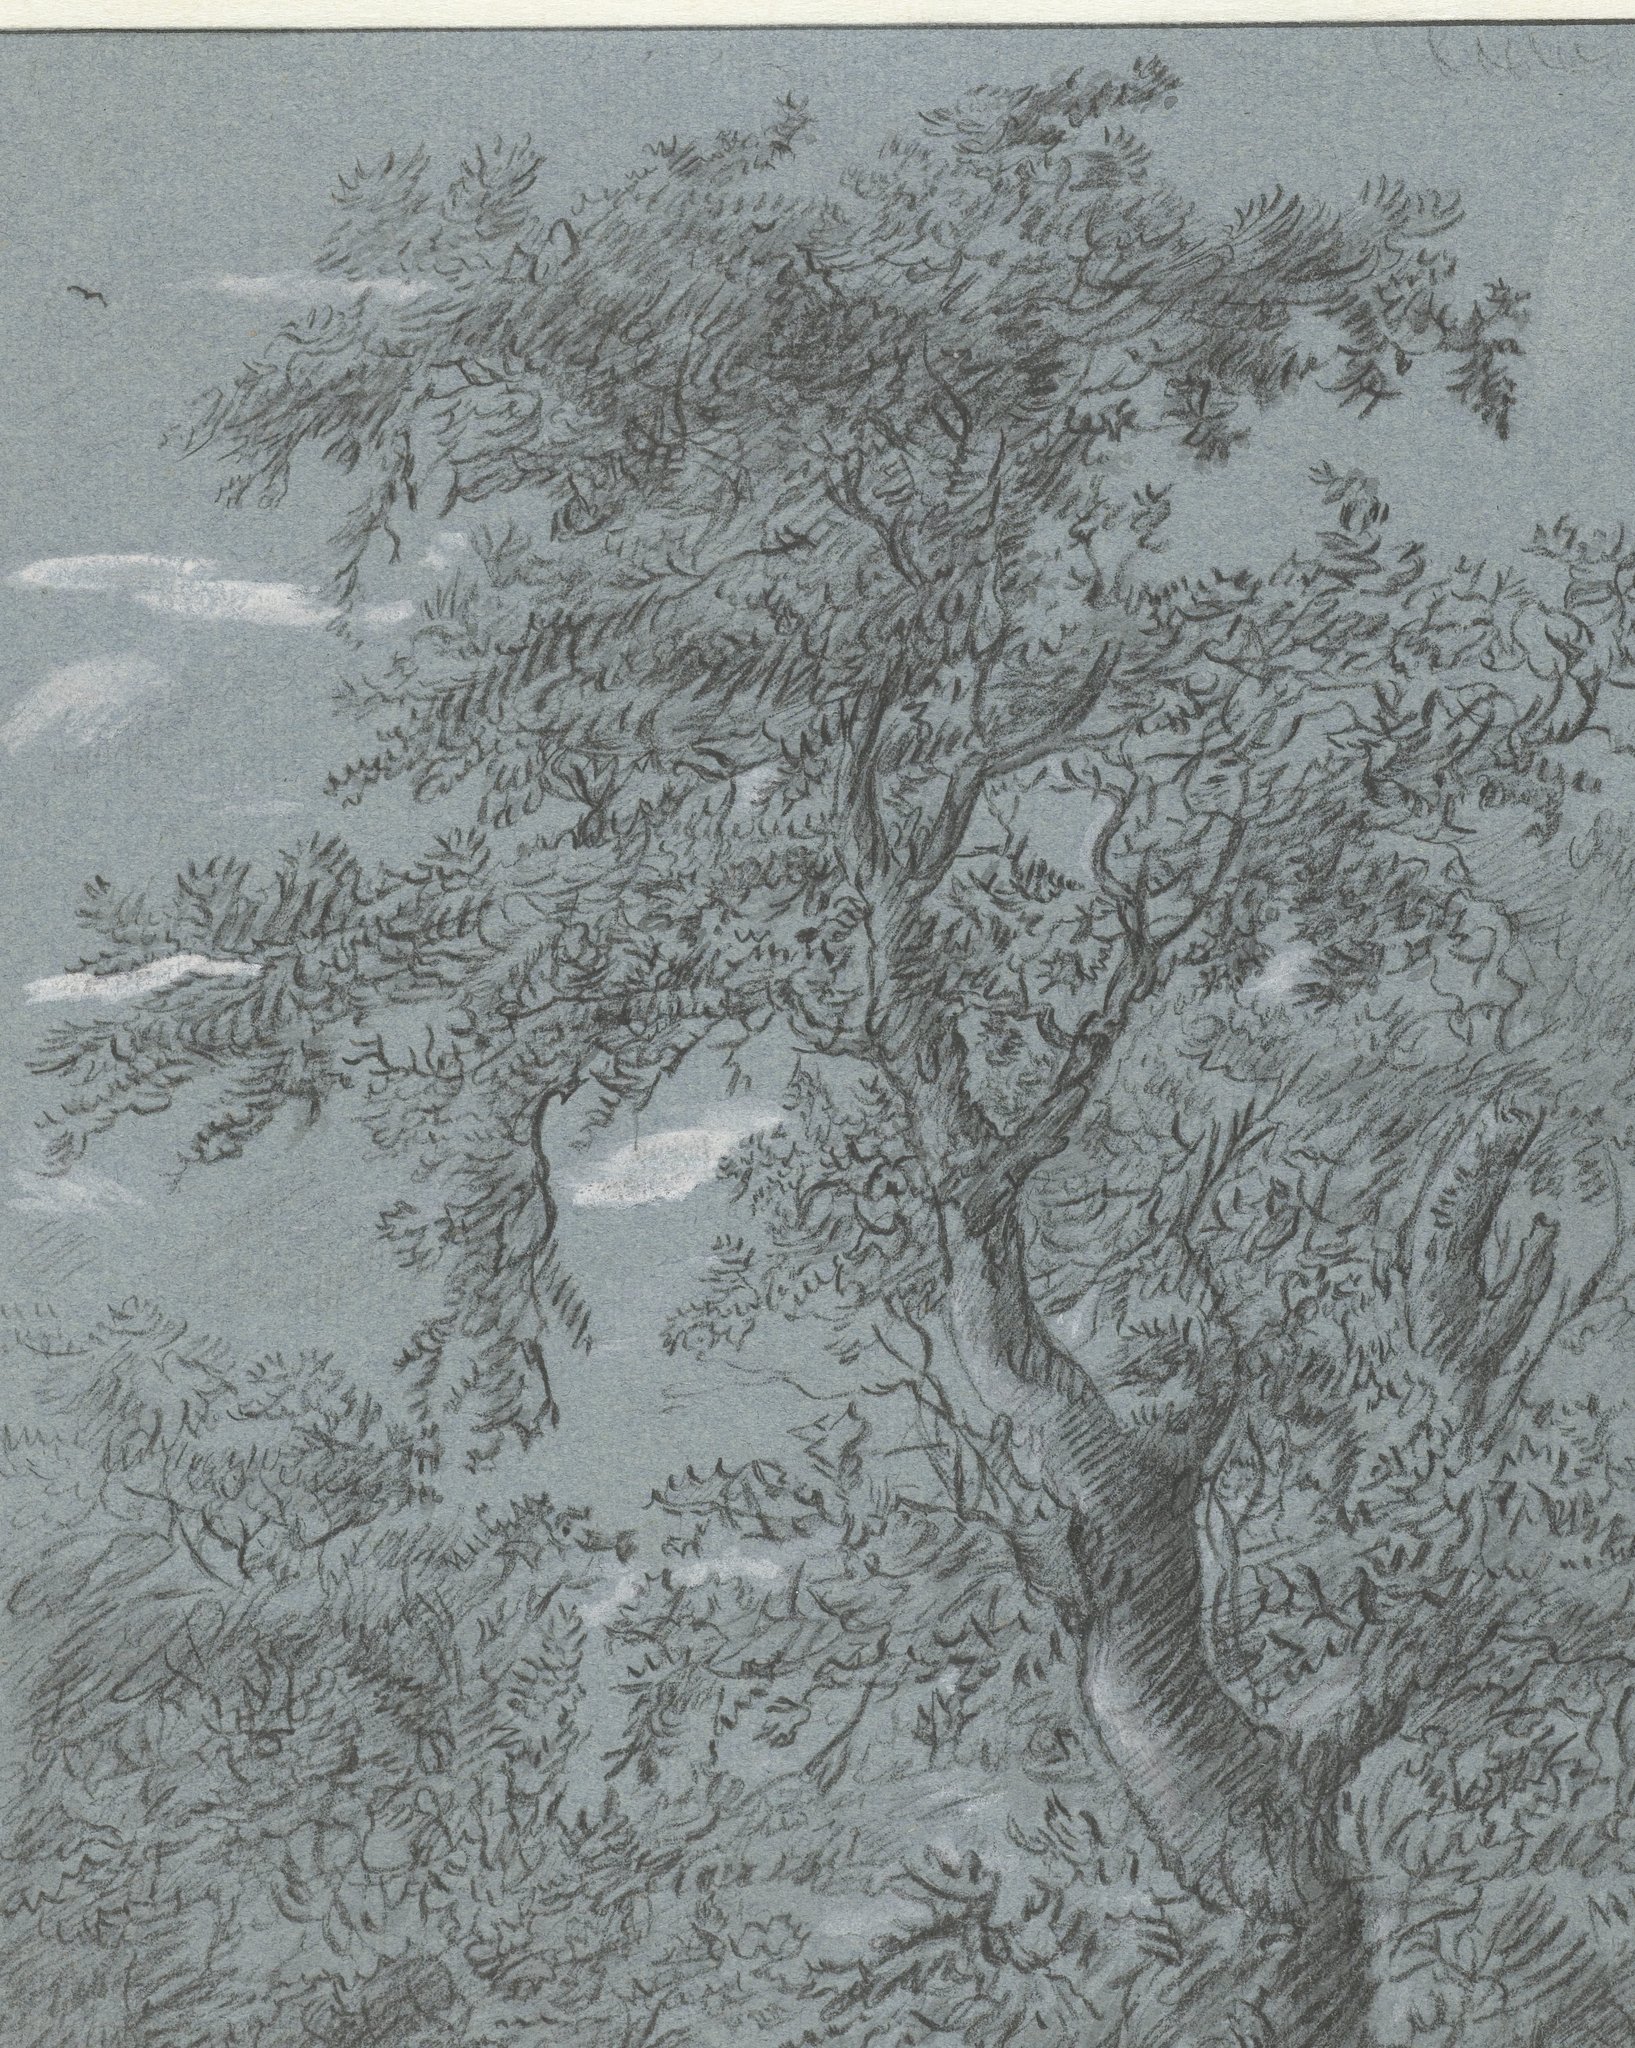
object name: drawing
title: Boomstudie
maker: joris van der haagen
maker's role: draughtsman, painter, print maker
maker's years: 1615-1669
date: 1625-1669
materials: chalk, paper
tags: trees